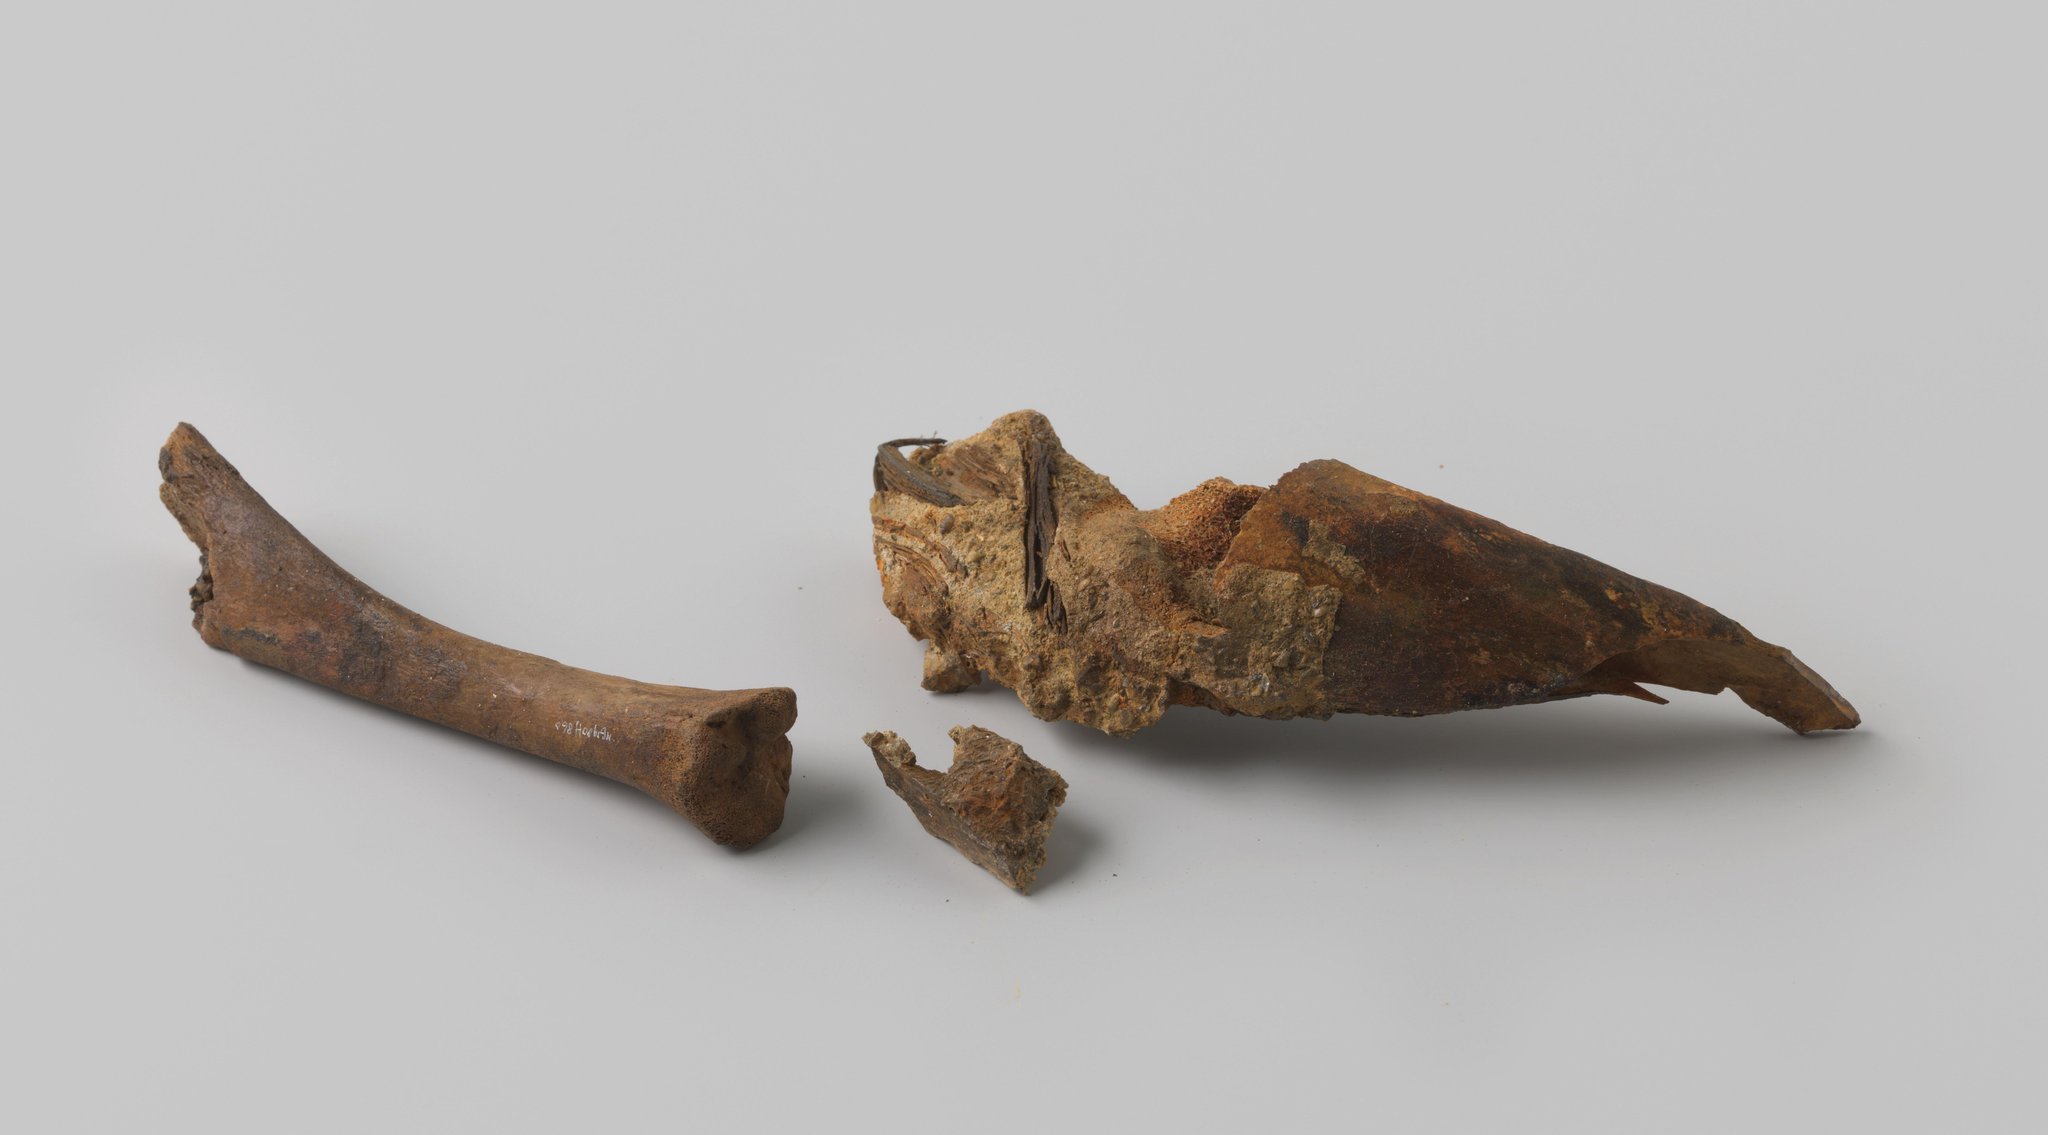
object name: bone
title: Fragmenten varkensbot uit het wrak van de Oost-Indiëvaarder Hollandia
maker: niet van toepassing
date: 1700-1743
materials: bone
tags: verenigde oostindische compagnie, hollandia (schip), annet